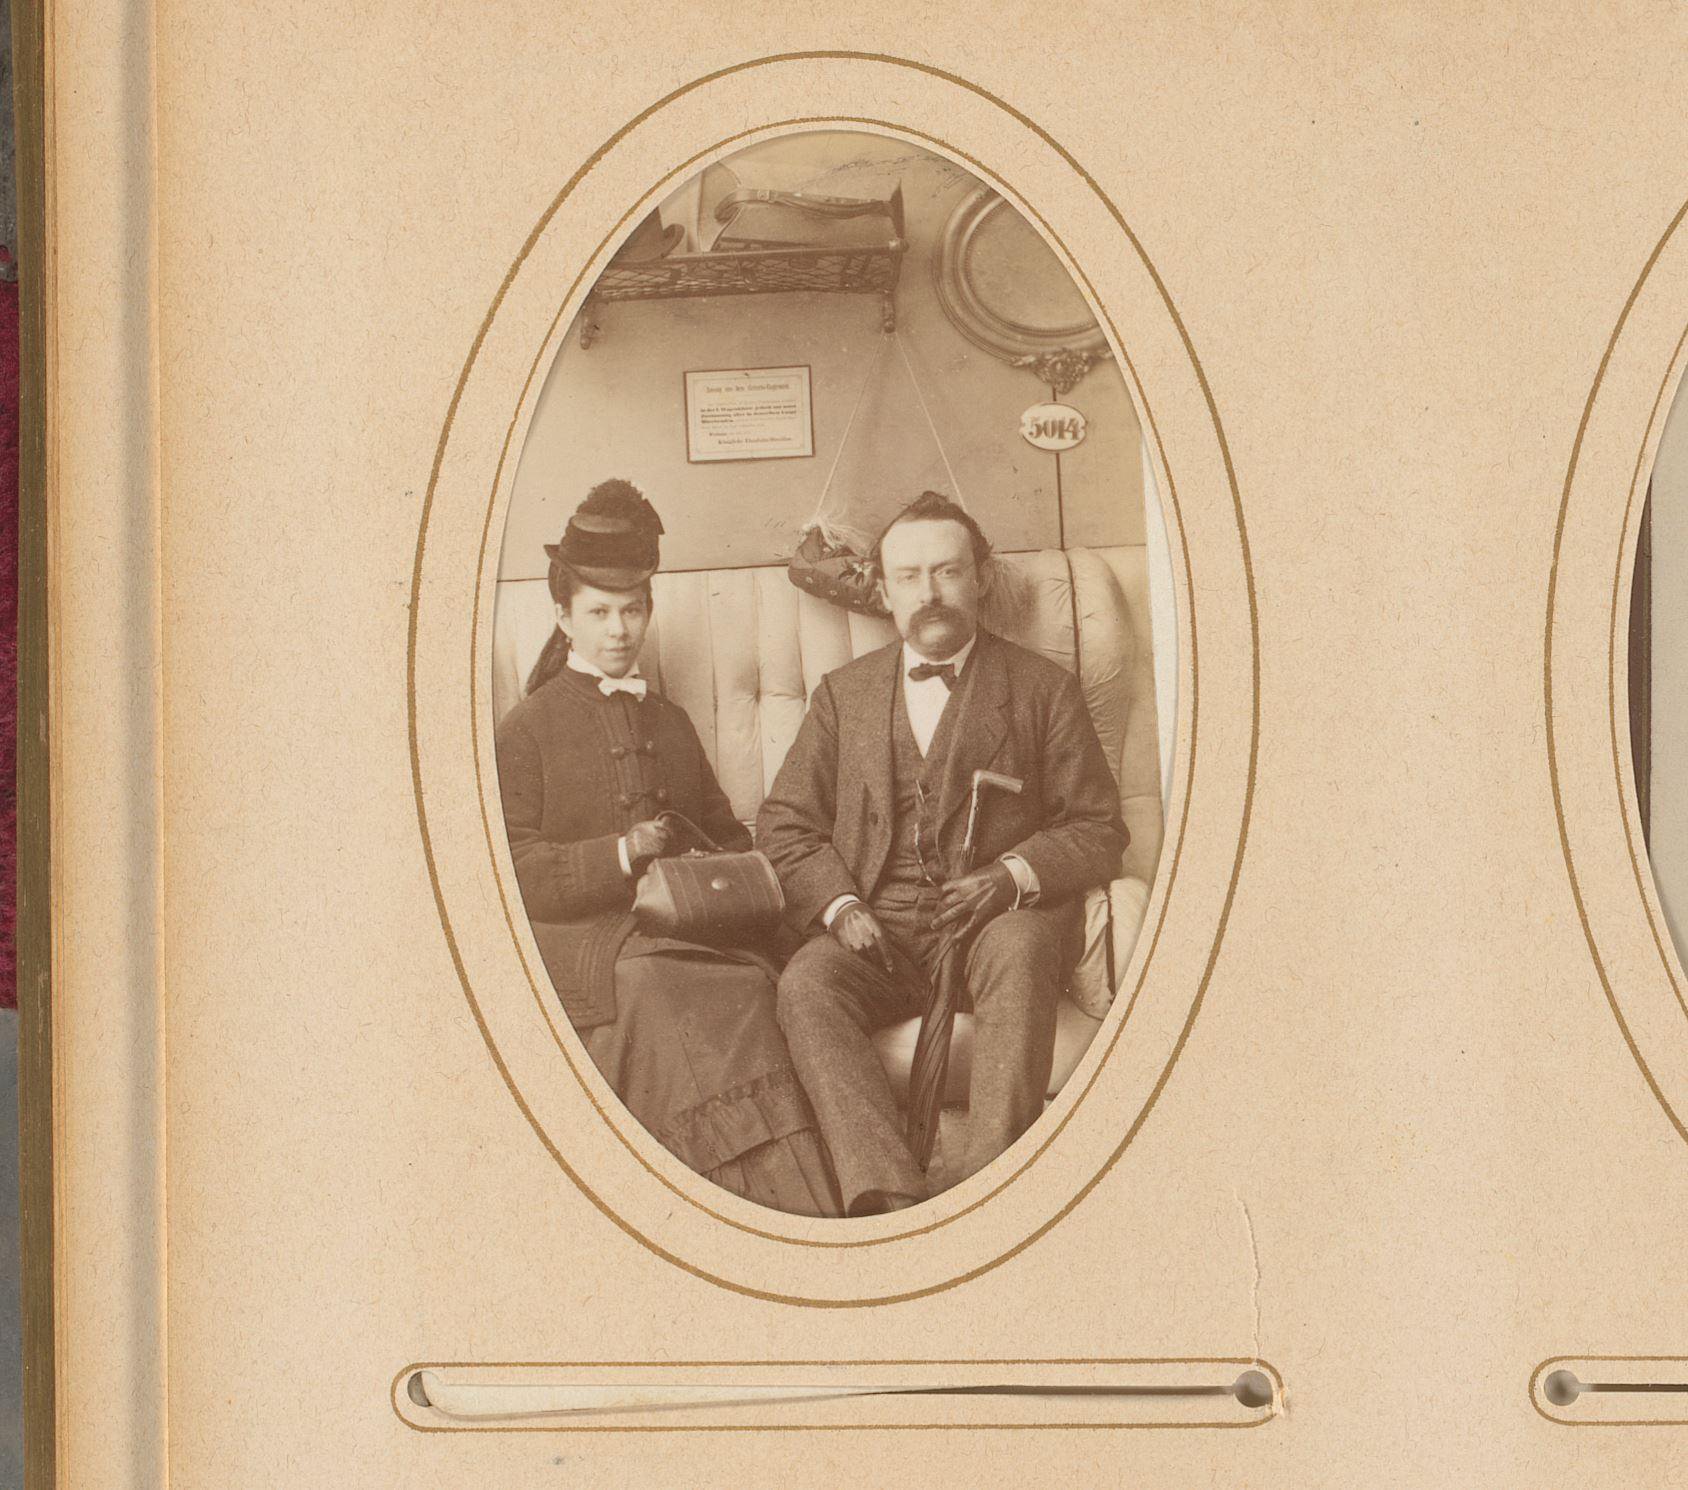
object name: album leaf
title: Portret van een vrouw en man in treinwagon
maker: carl borntraeger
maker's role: fotograaf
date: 1873-1900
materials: cardboard, photographic support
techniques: albumen print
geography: wiesbaden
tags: historical persons - bb - woman, historical persons, passenger carriage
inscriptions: inscription: ‘1873/ Verdienstmedaille/ Carl Borntraeger/ Atelier für Photographie und unvergänglichen Pressendruck/ Wiesbaden (...)’